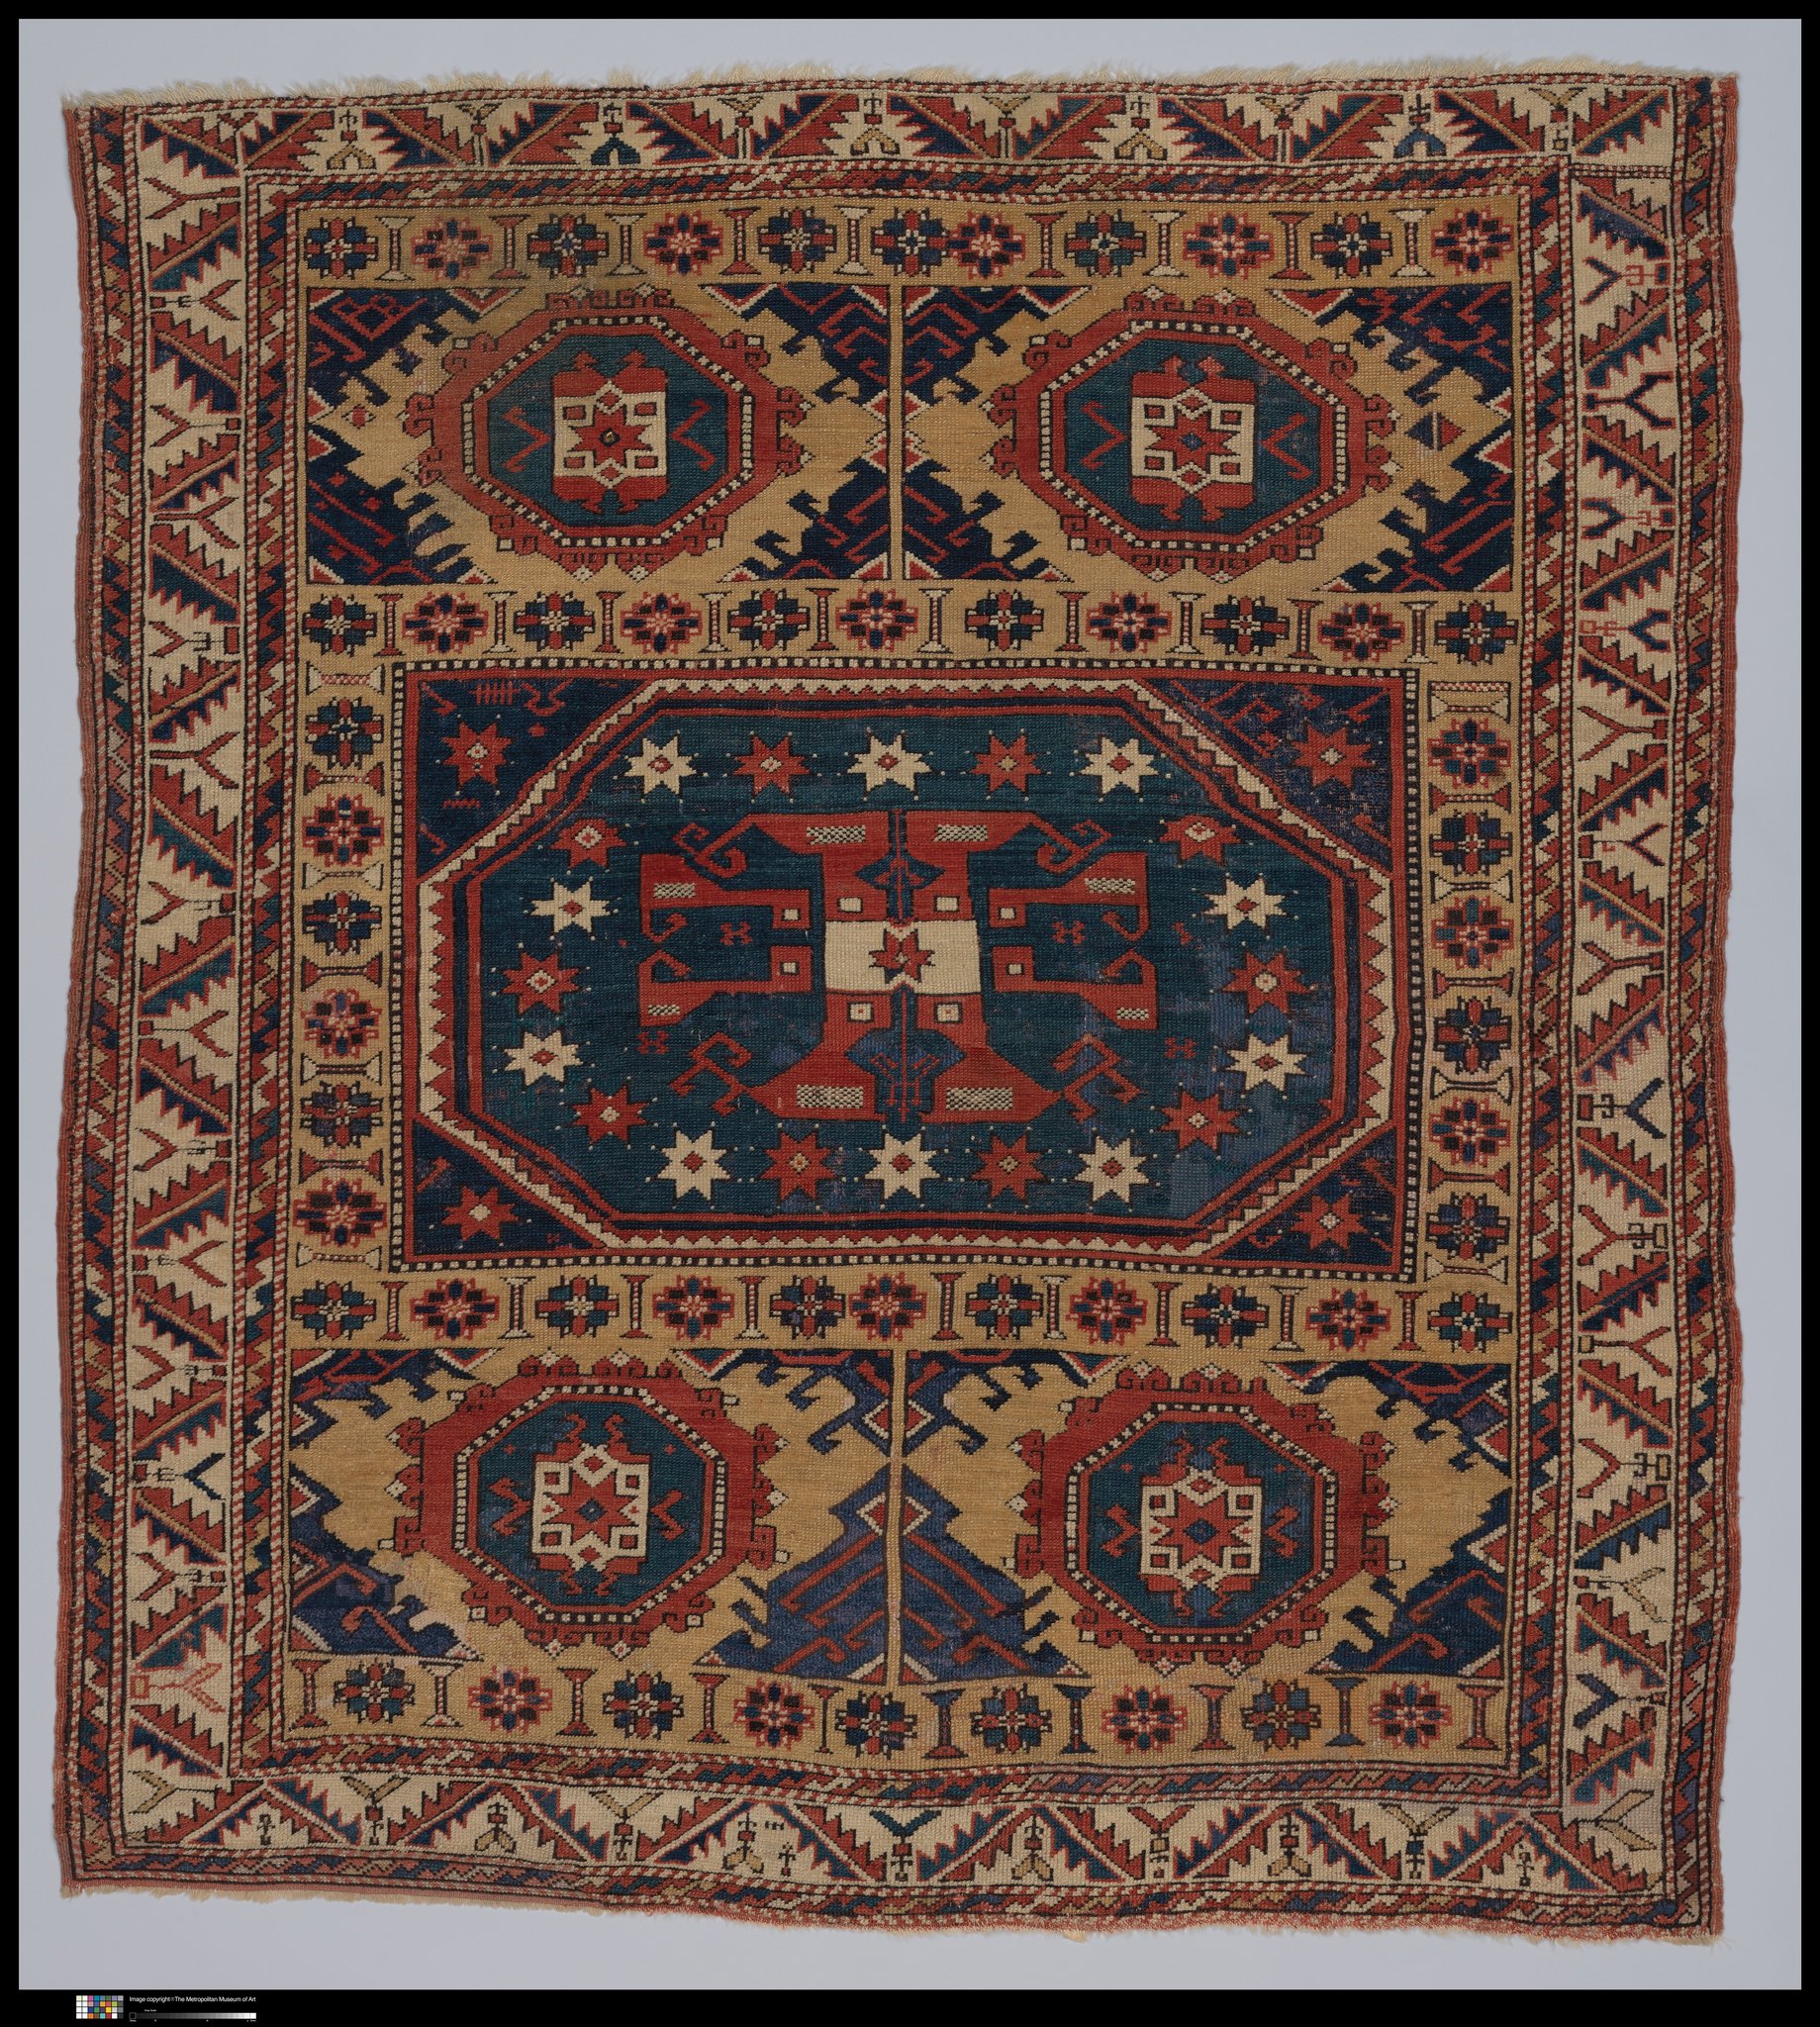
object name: carpet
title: Holbein Ezine Carpet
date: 1801-1833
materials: wool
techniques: pile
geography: turkey